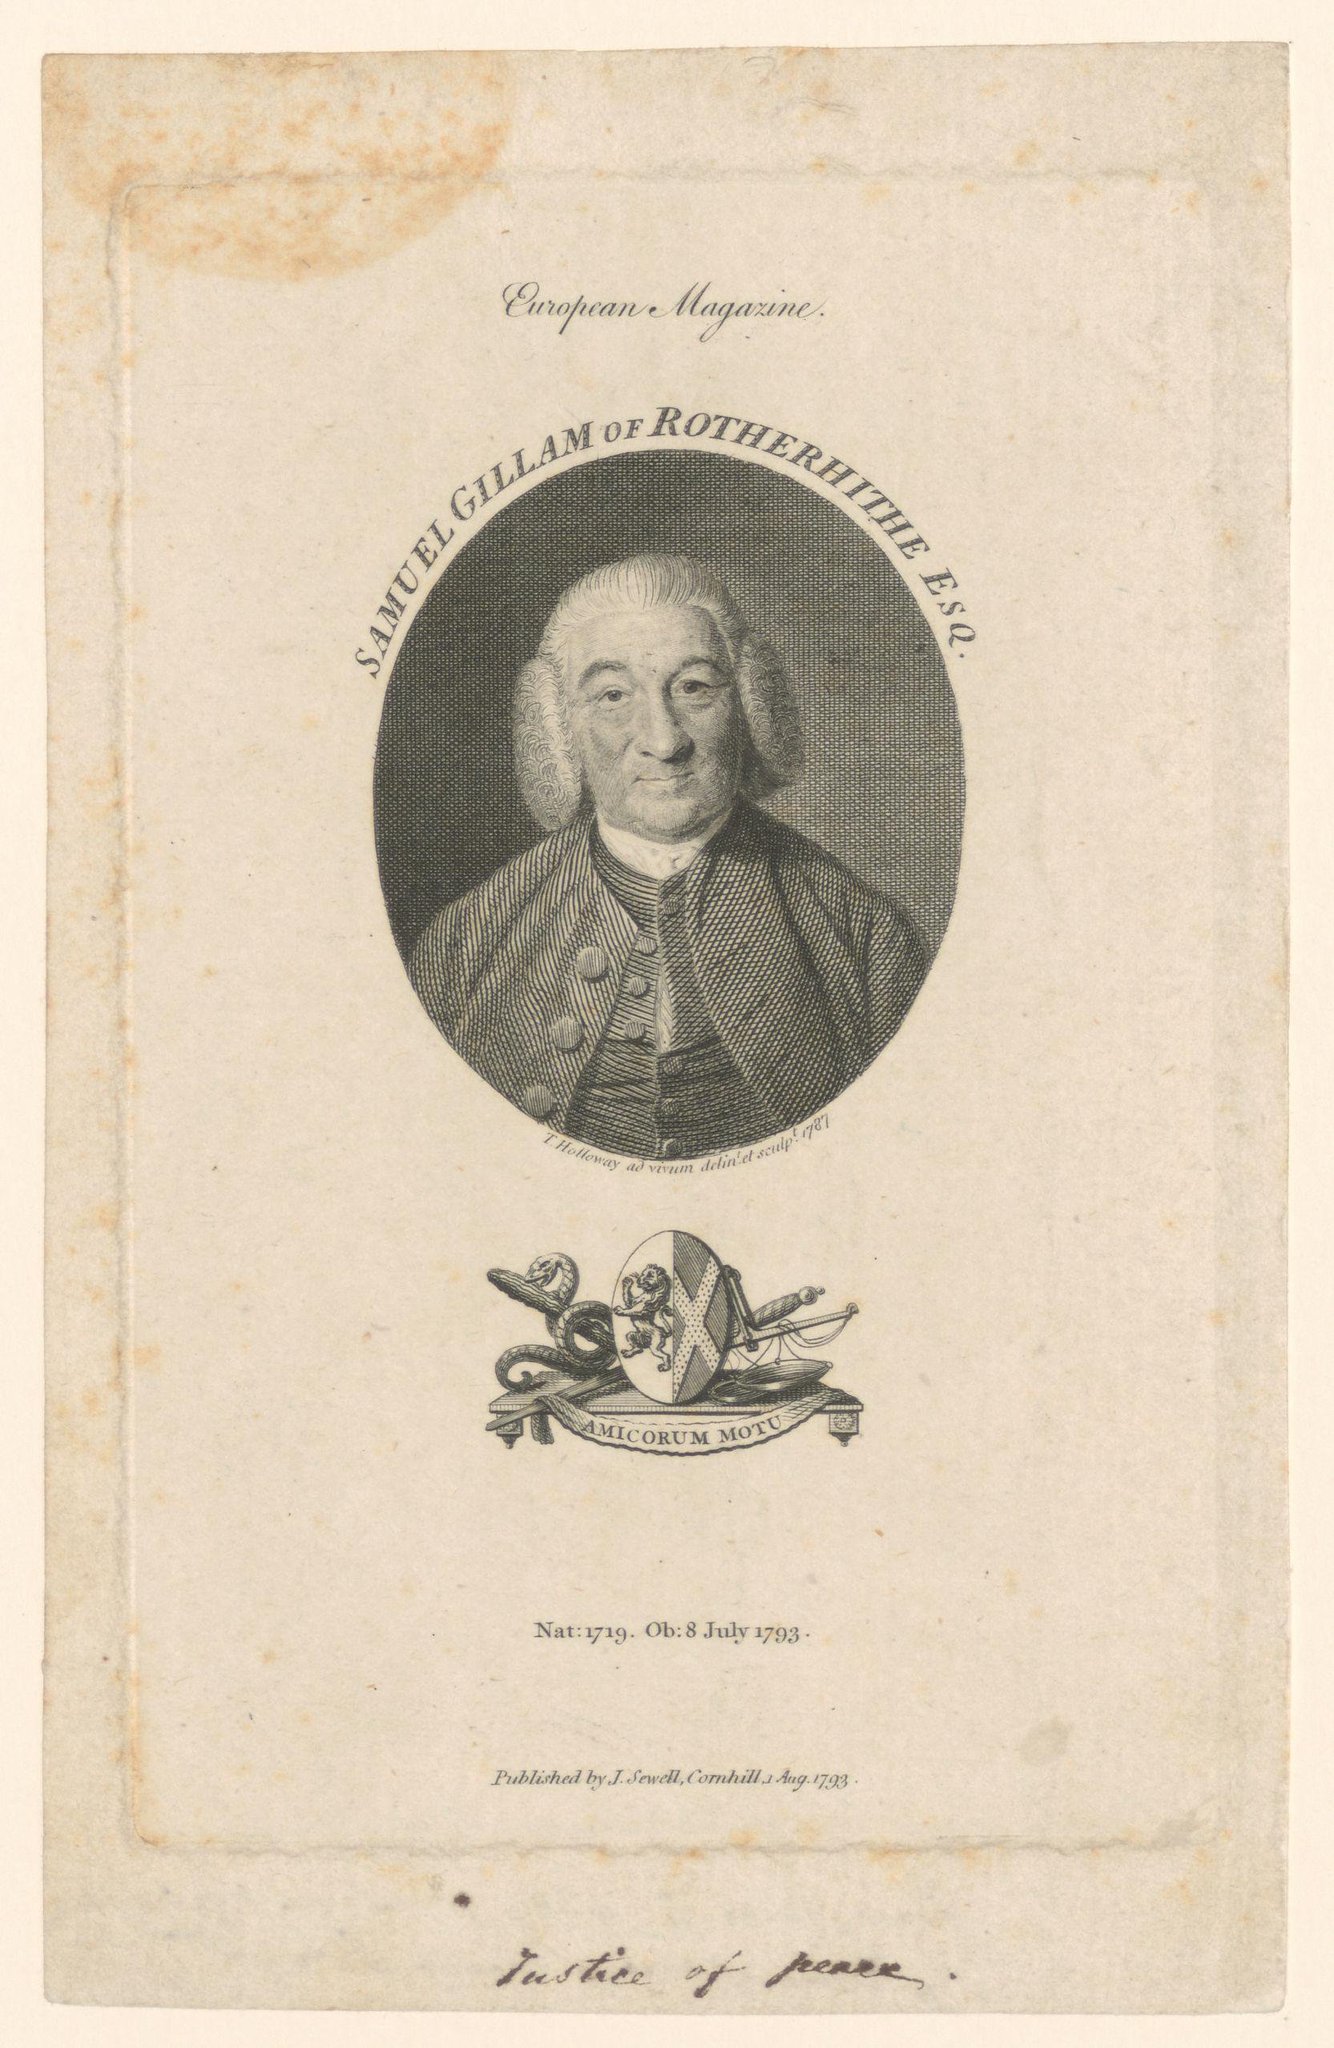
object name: print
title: Samuel Gillam of Rotherhithe Esq.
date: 1787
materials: paper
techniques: etching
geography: london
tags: historical persons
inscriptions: collector's mark: Lugt 2228, inscription: ‘Justice of Peace’, inscription: ‘Evans [...] Justice of Peace; county Surrey’